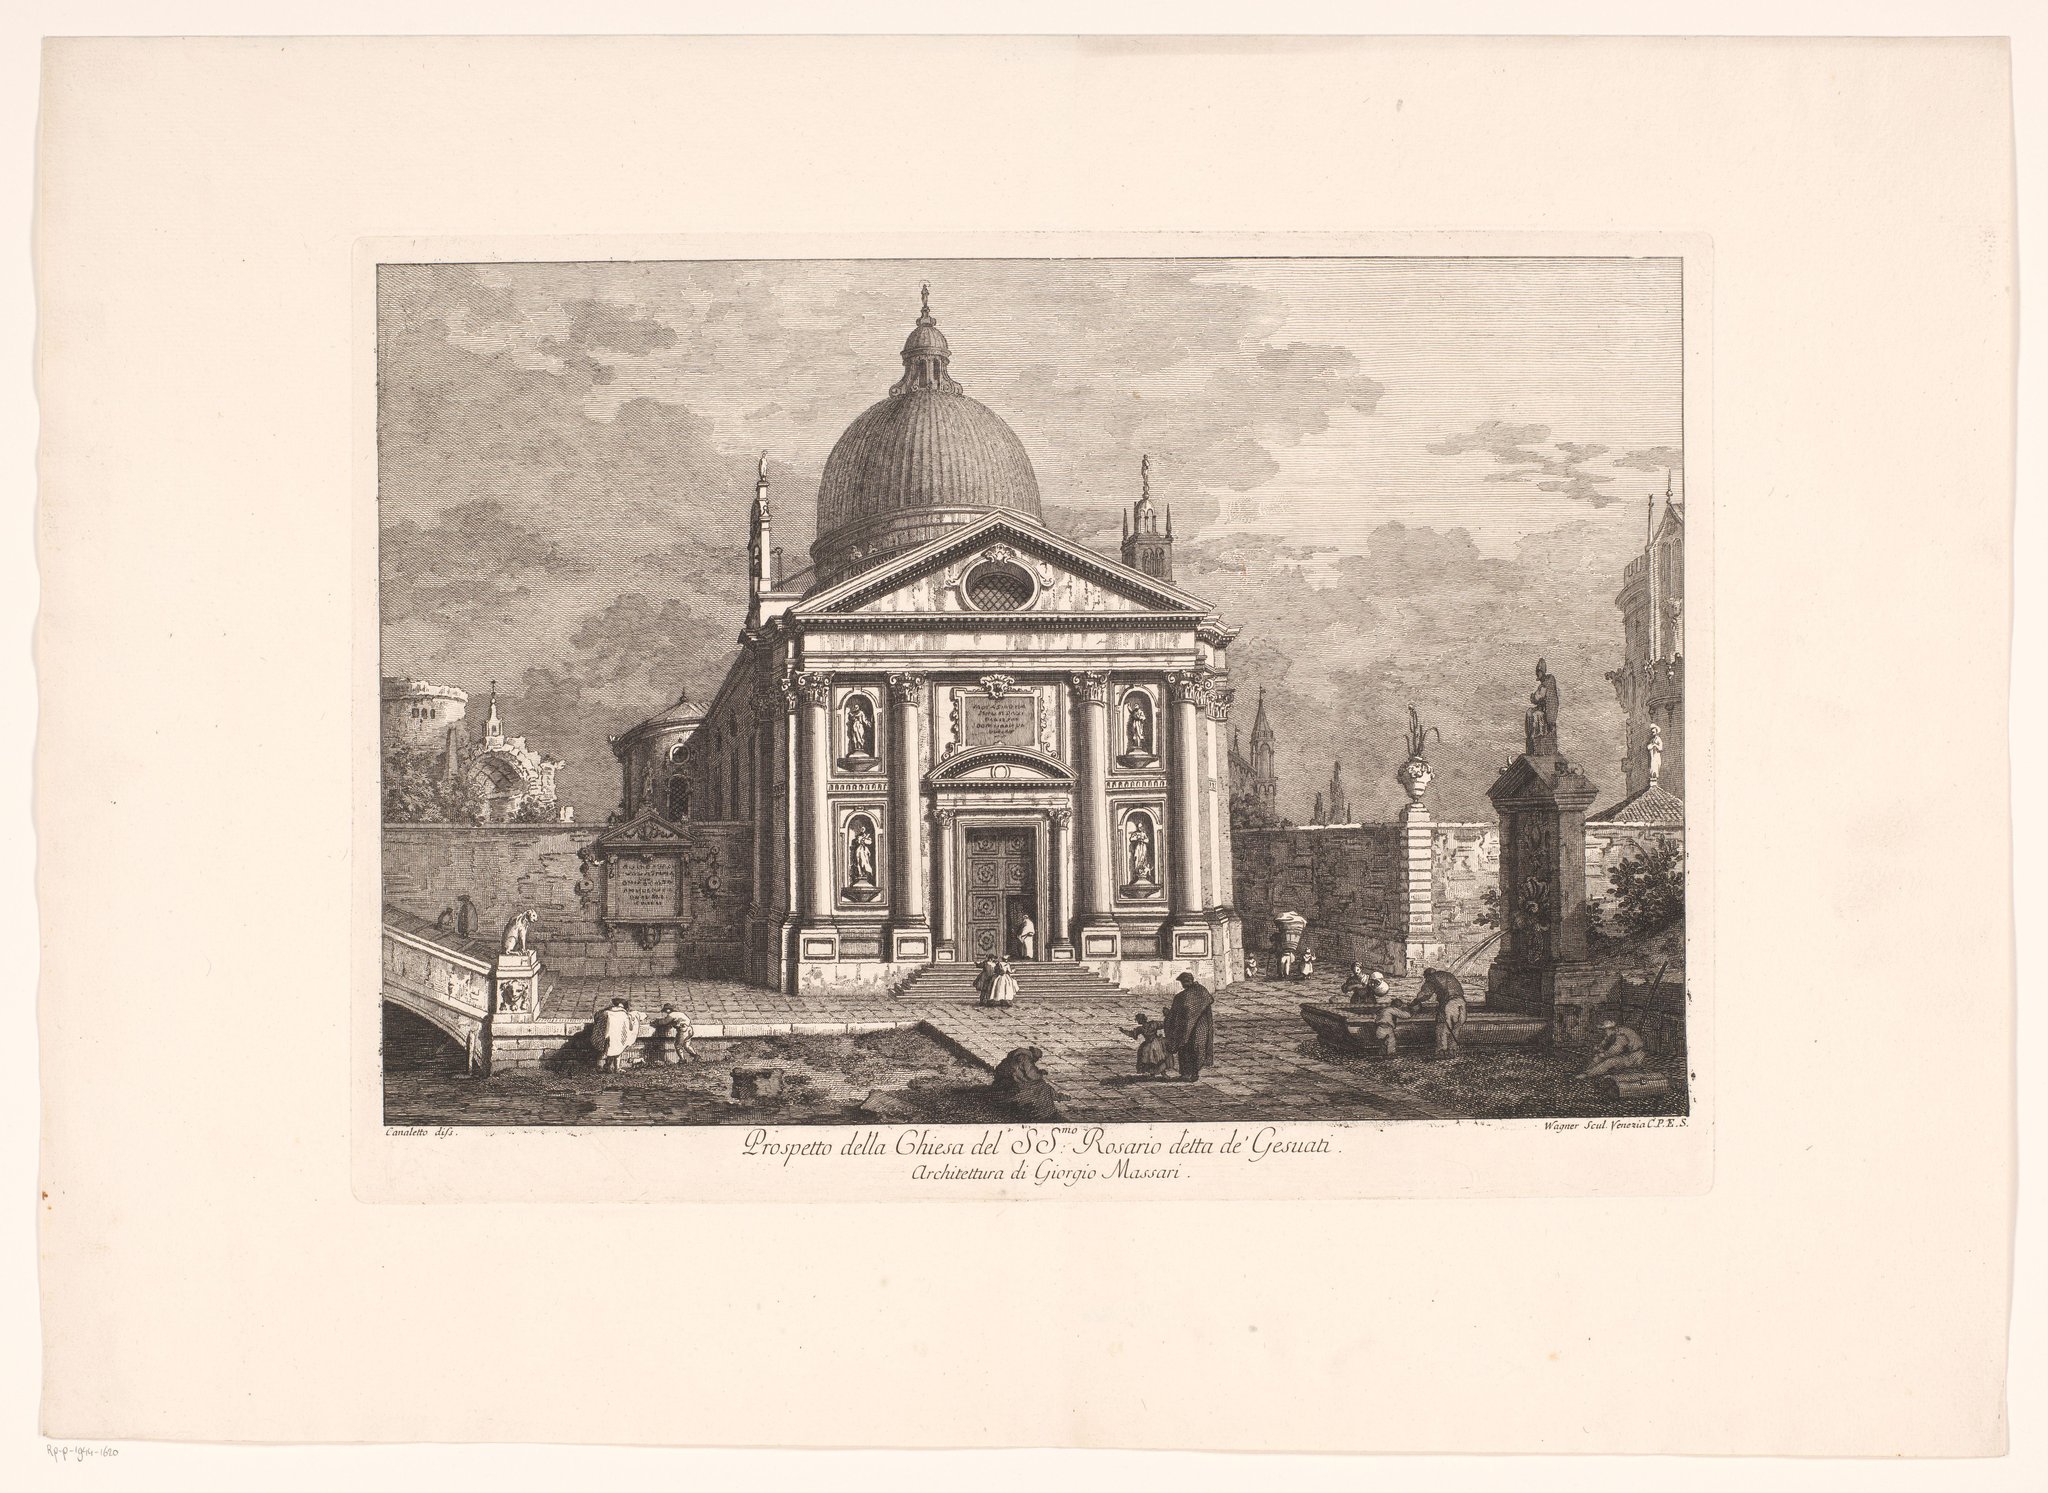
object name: print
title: Prospetto della Chiesa del S.S. Rosario detta de Gesuati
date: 1755-1780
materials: paper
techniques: etching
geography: italy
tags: church (exterior)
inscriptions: collector's mark: Lugt 2228